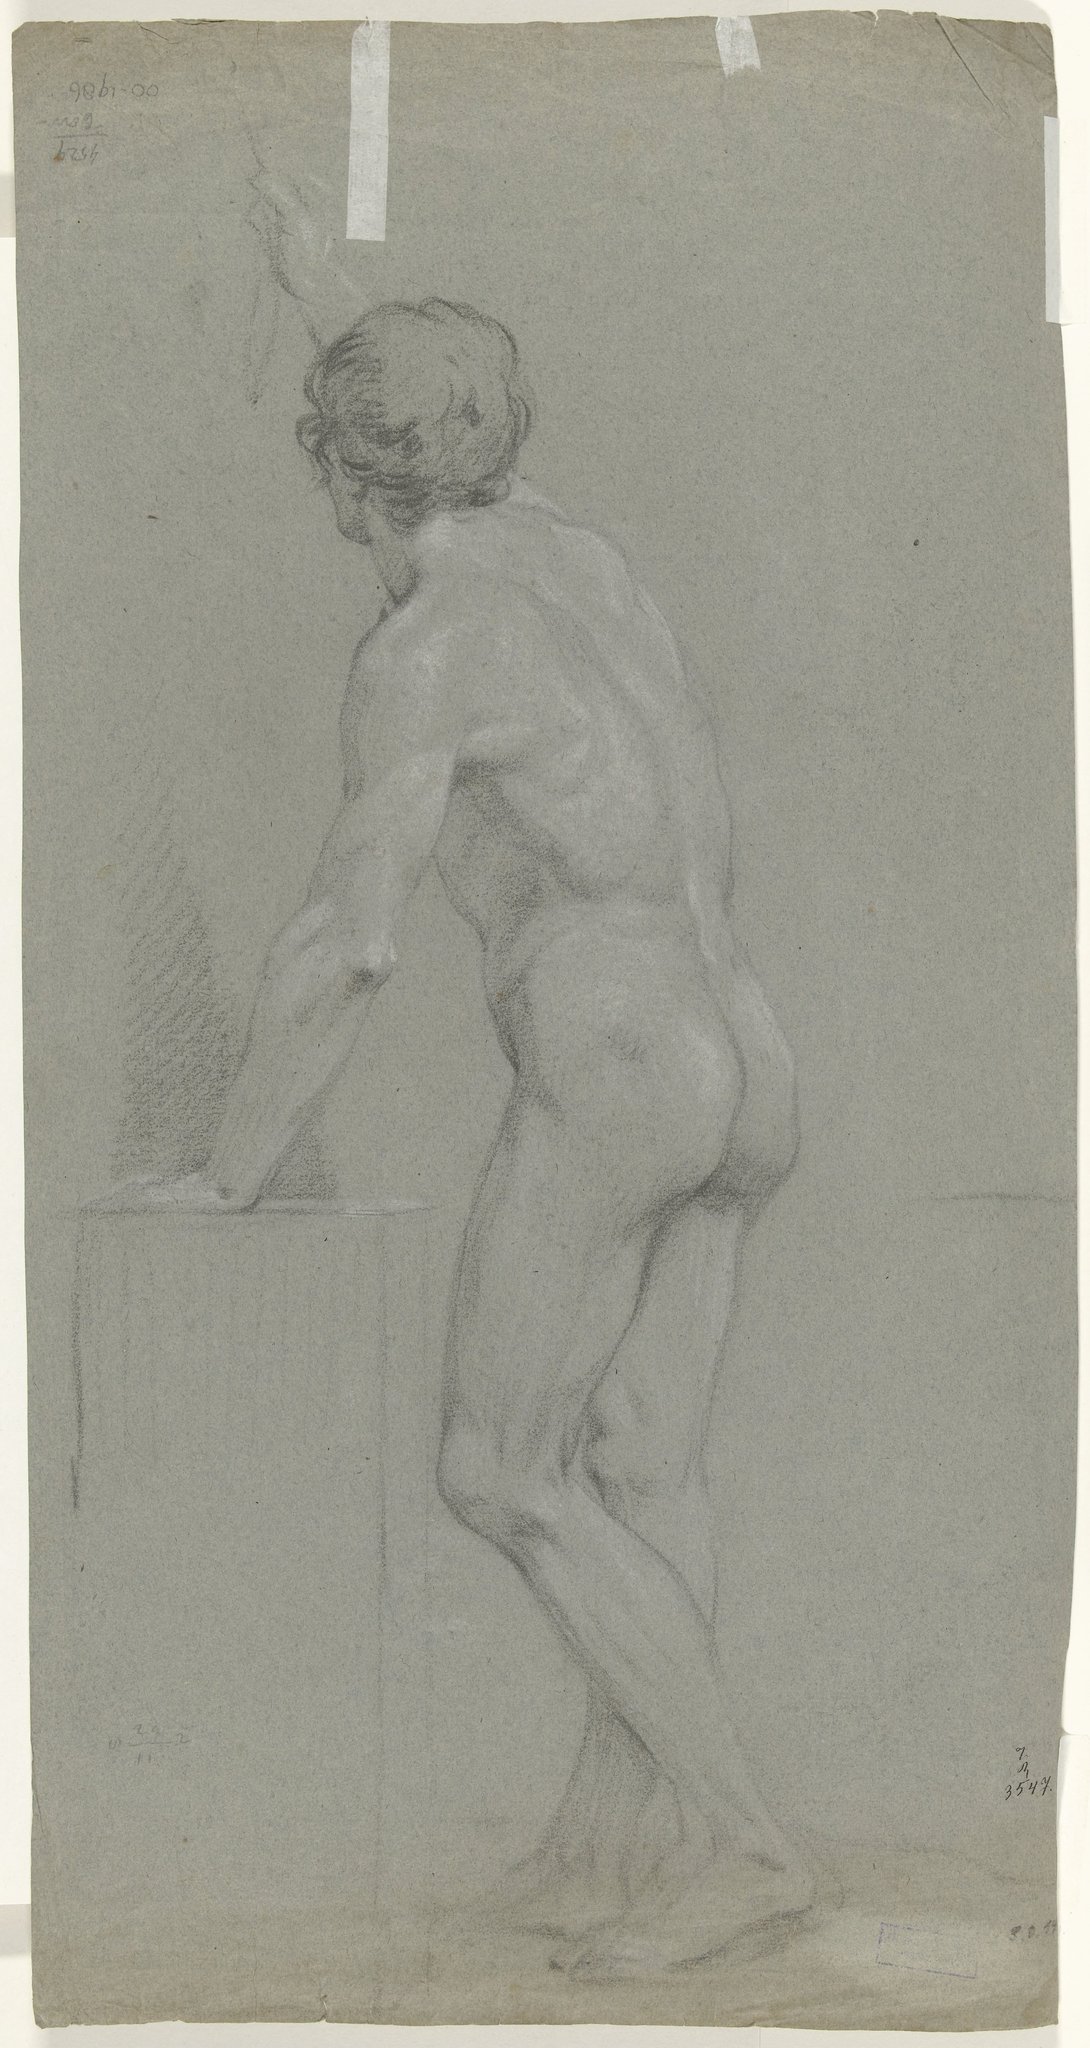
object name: drawing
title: Staand mannelijk naakt, op de rug gezien naar links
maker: Anonymous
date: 1747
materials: chalk, paper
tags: standing figure